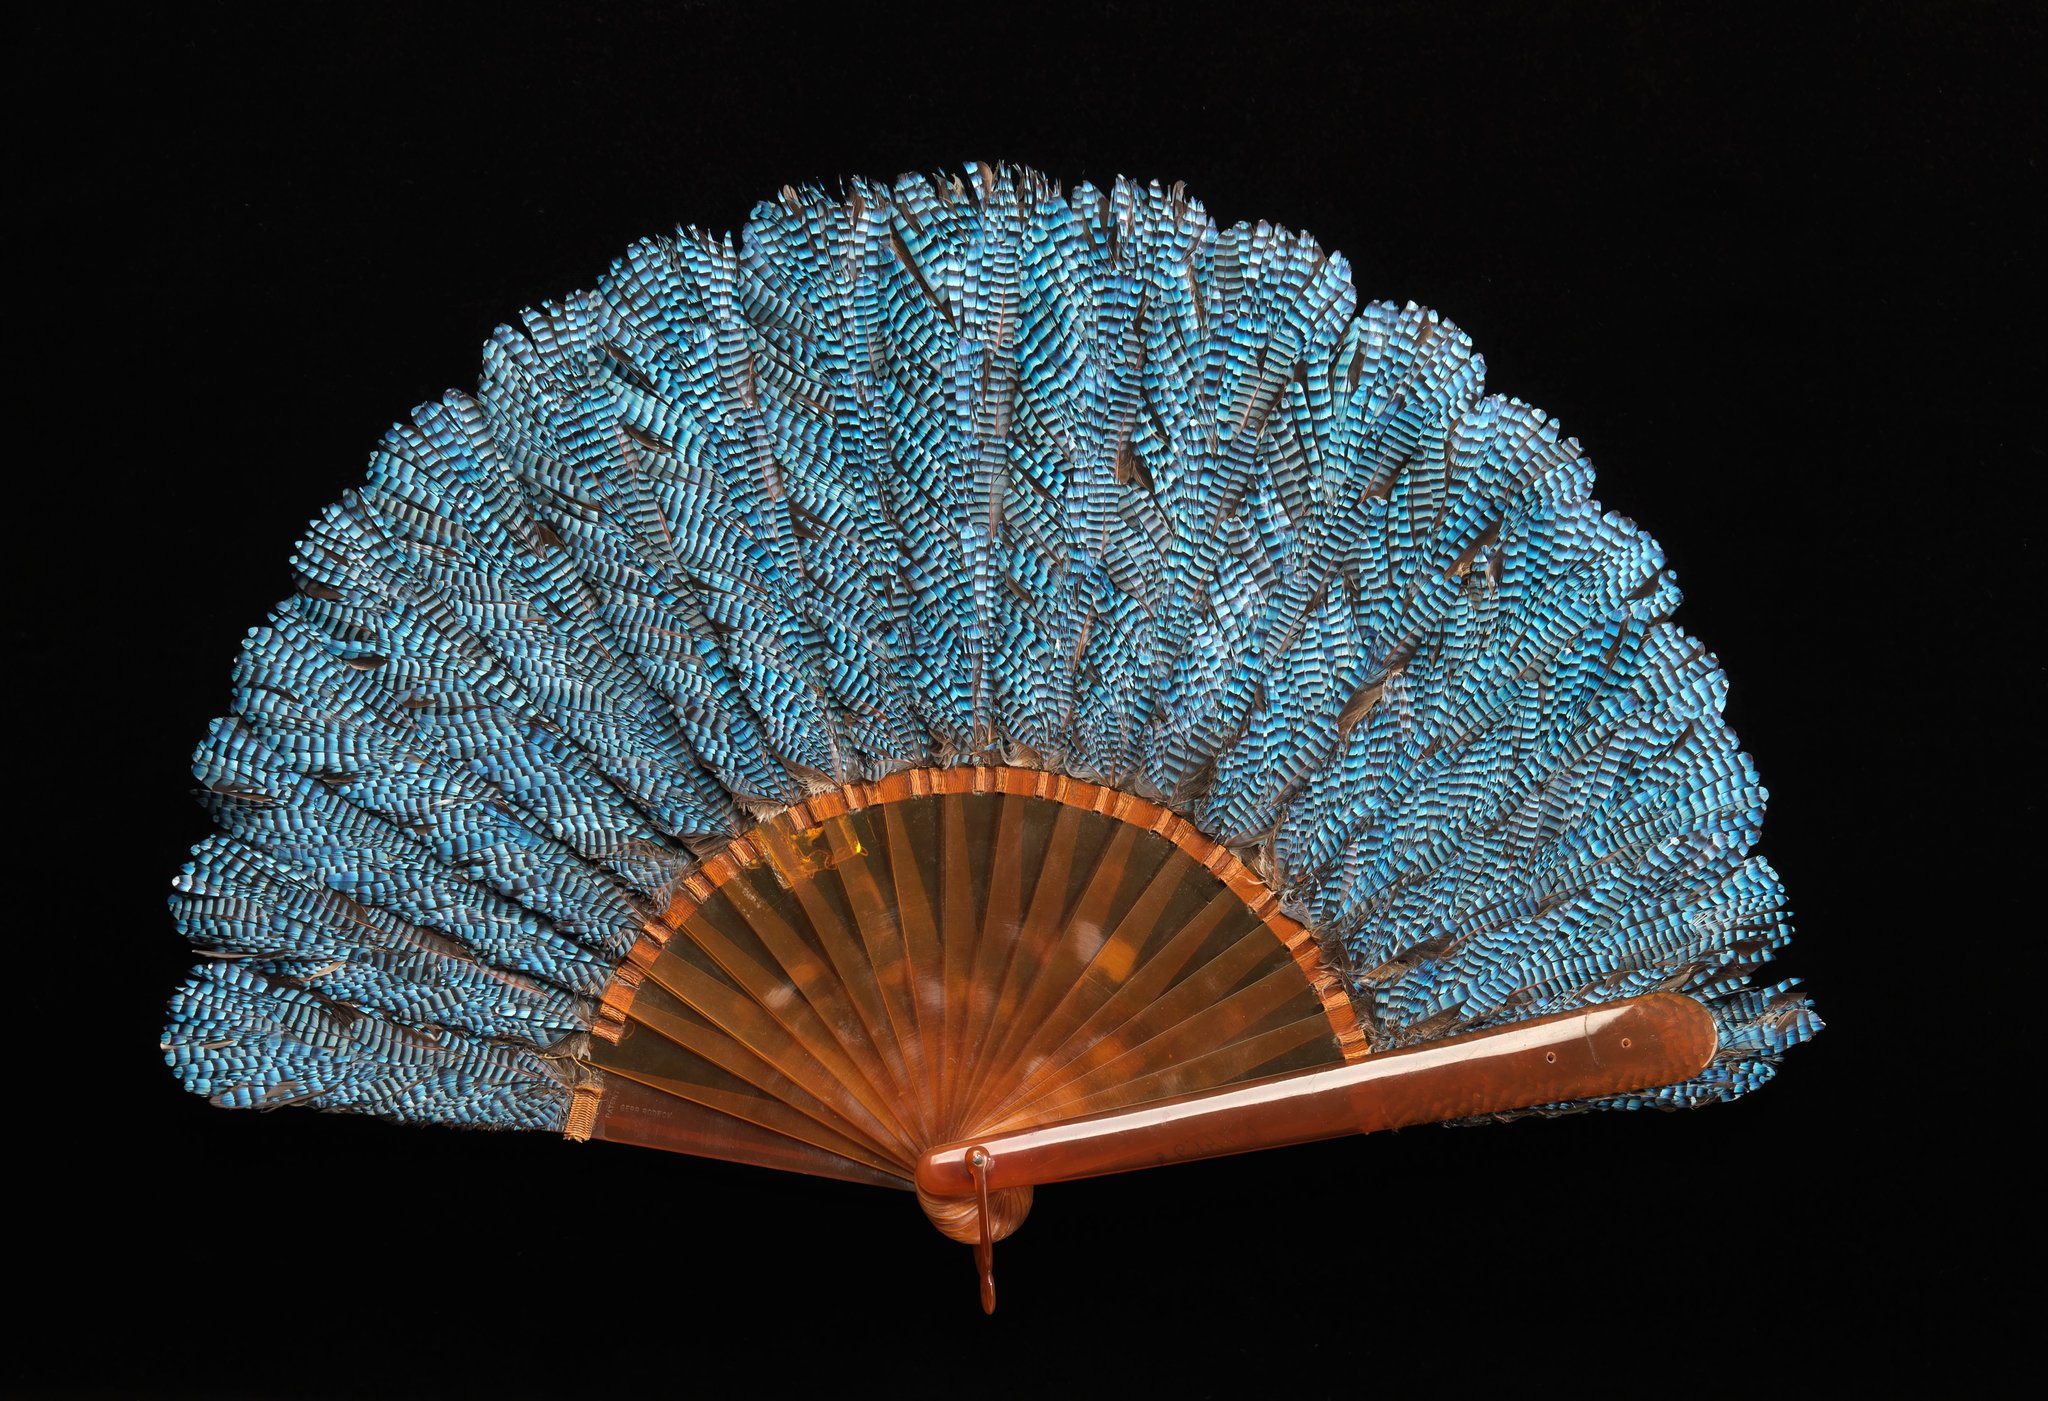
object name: fan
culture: austrian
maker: rodeck brothers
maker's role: designer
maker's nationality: austrian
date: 1895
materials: feather, silk, shell